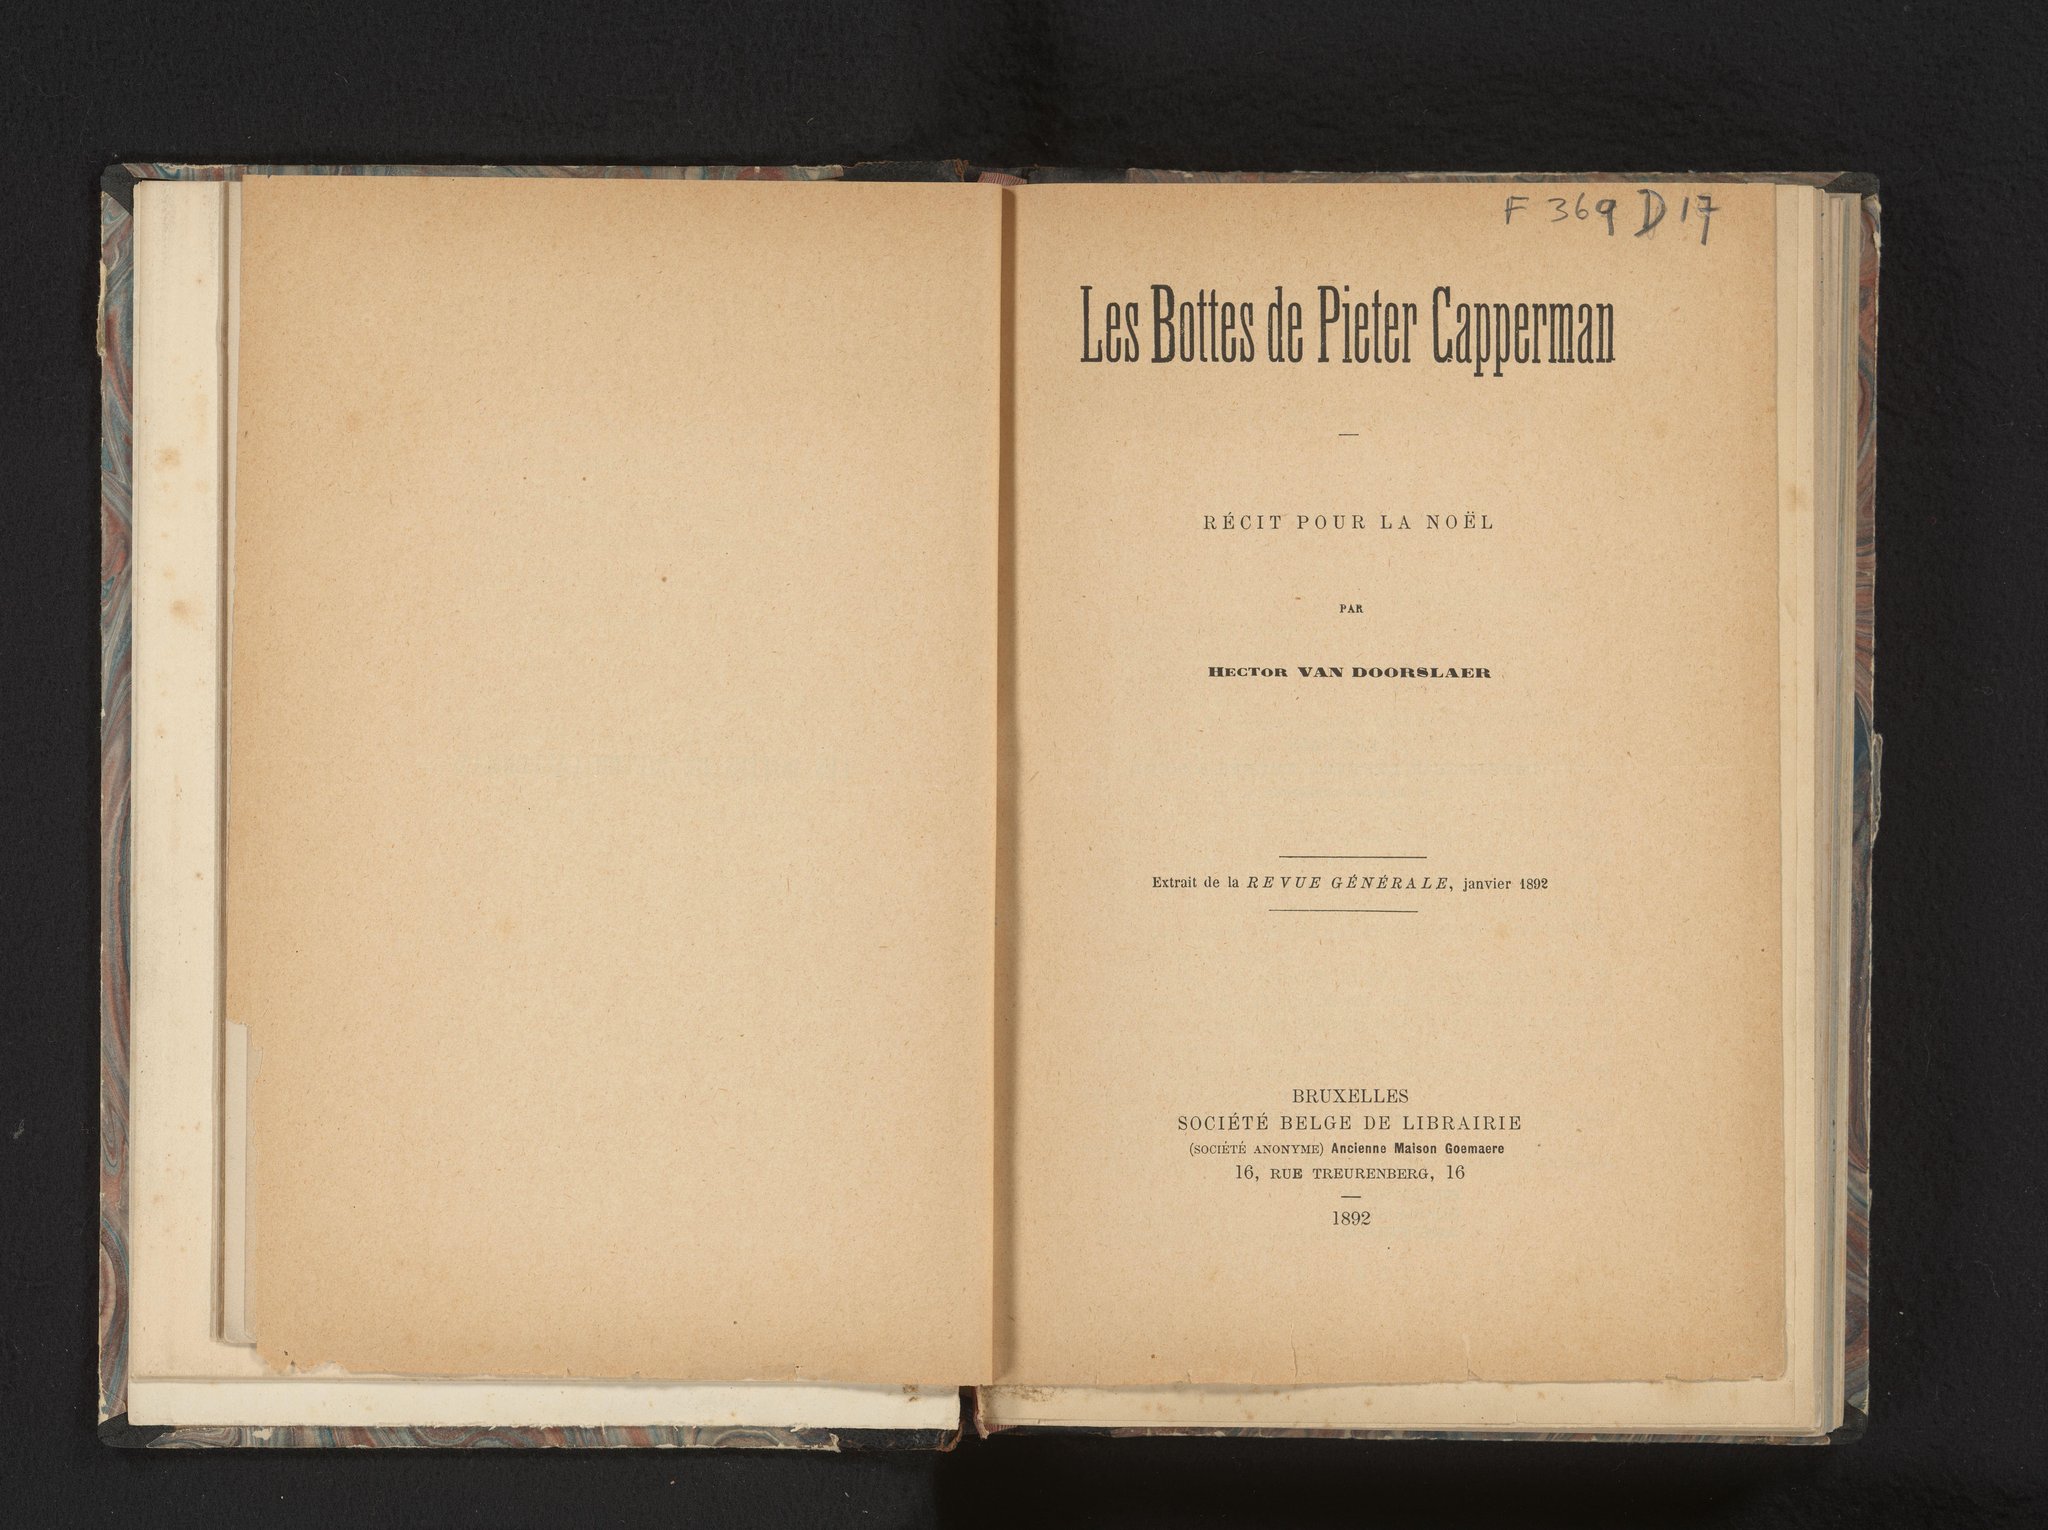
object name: book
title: Les bottes de Pieter Capperman : récit pour la noël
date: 1892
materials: linen, paper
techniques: printing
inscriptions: number: ‘2.000-’, date: ‘Jan 1992’, bookplate: ‘Comtede Kerchove de Denterghem’